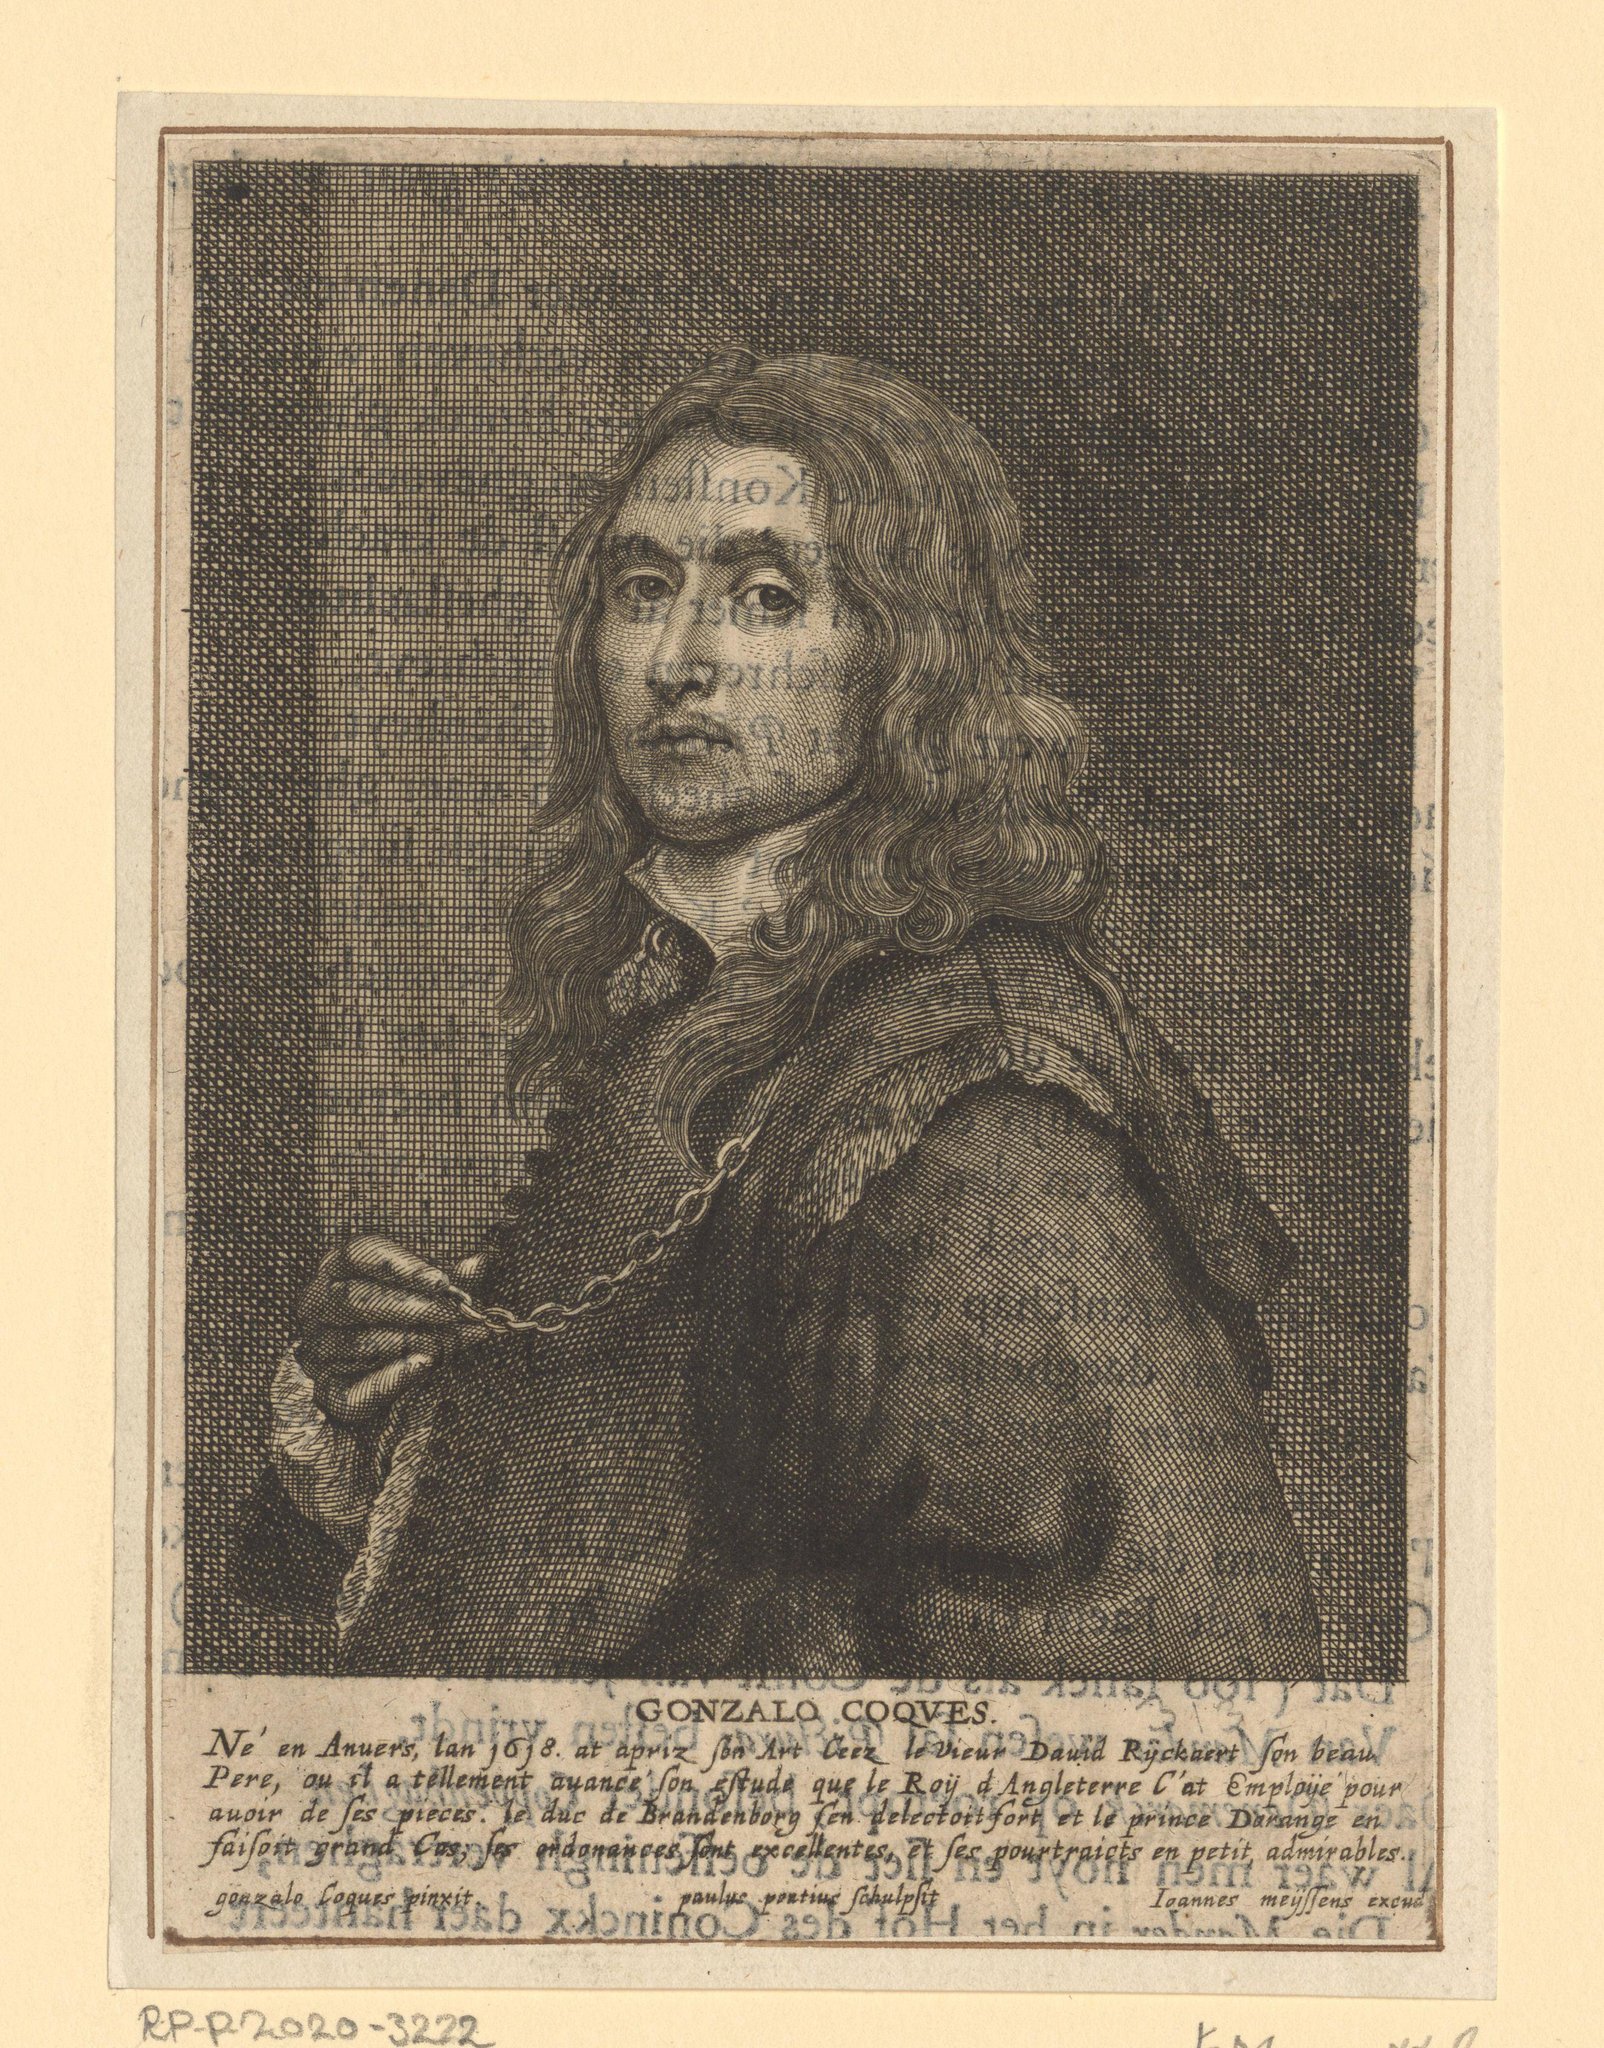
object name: print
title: Portret van Athanase Laurent Charles Coquerel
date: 1662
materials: paper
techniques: engraving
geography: new york city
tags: gonzales coques, historical persons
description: Prent uit: Bie, Cornelis de. Het gulden cabinet vande edele vry schilder-const (...). Antwerpen: Juriaen van Montfort, 1662. Prent ook gebruikt in eerdere editie (1661).